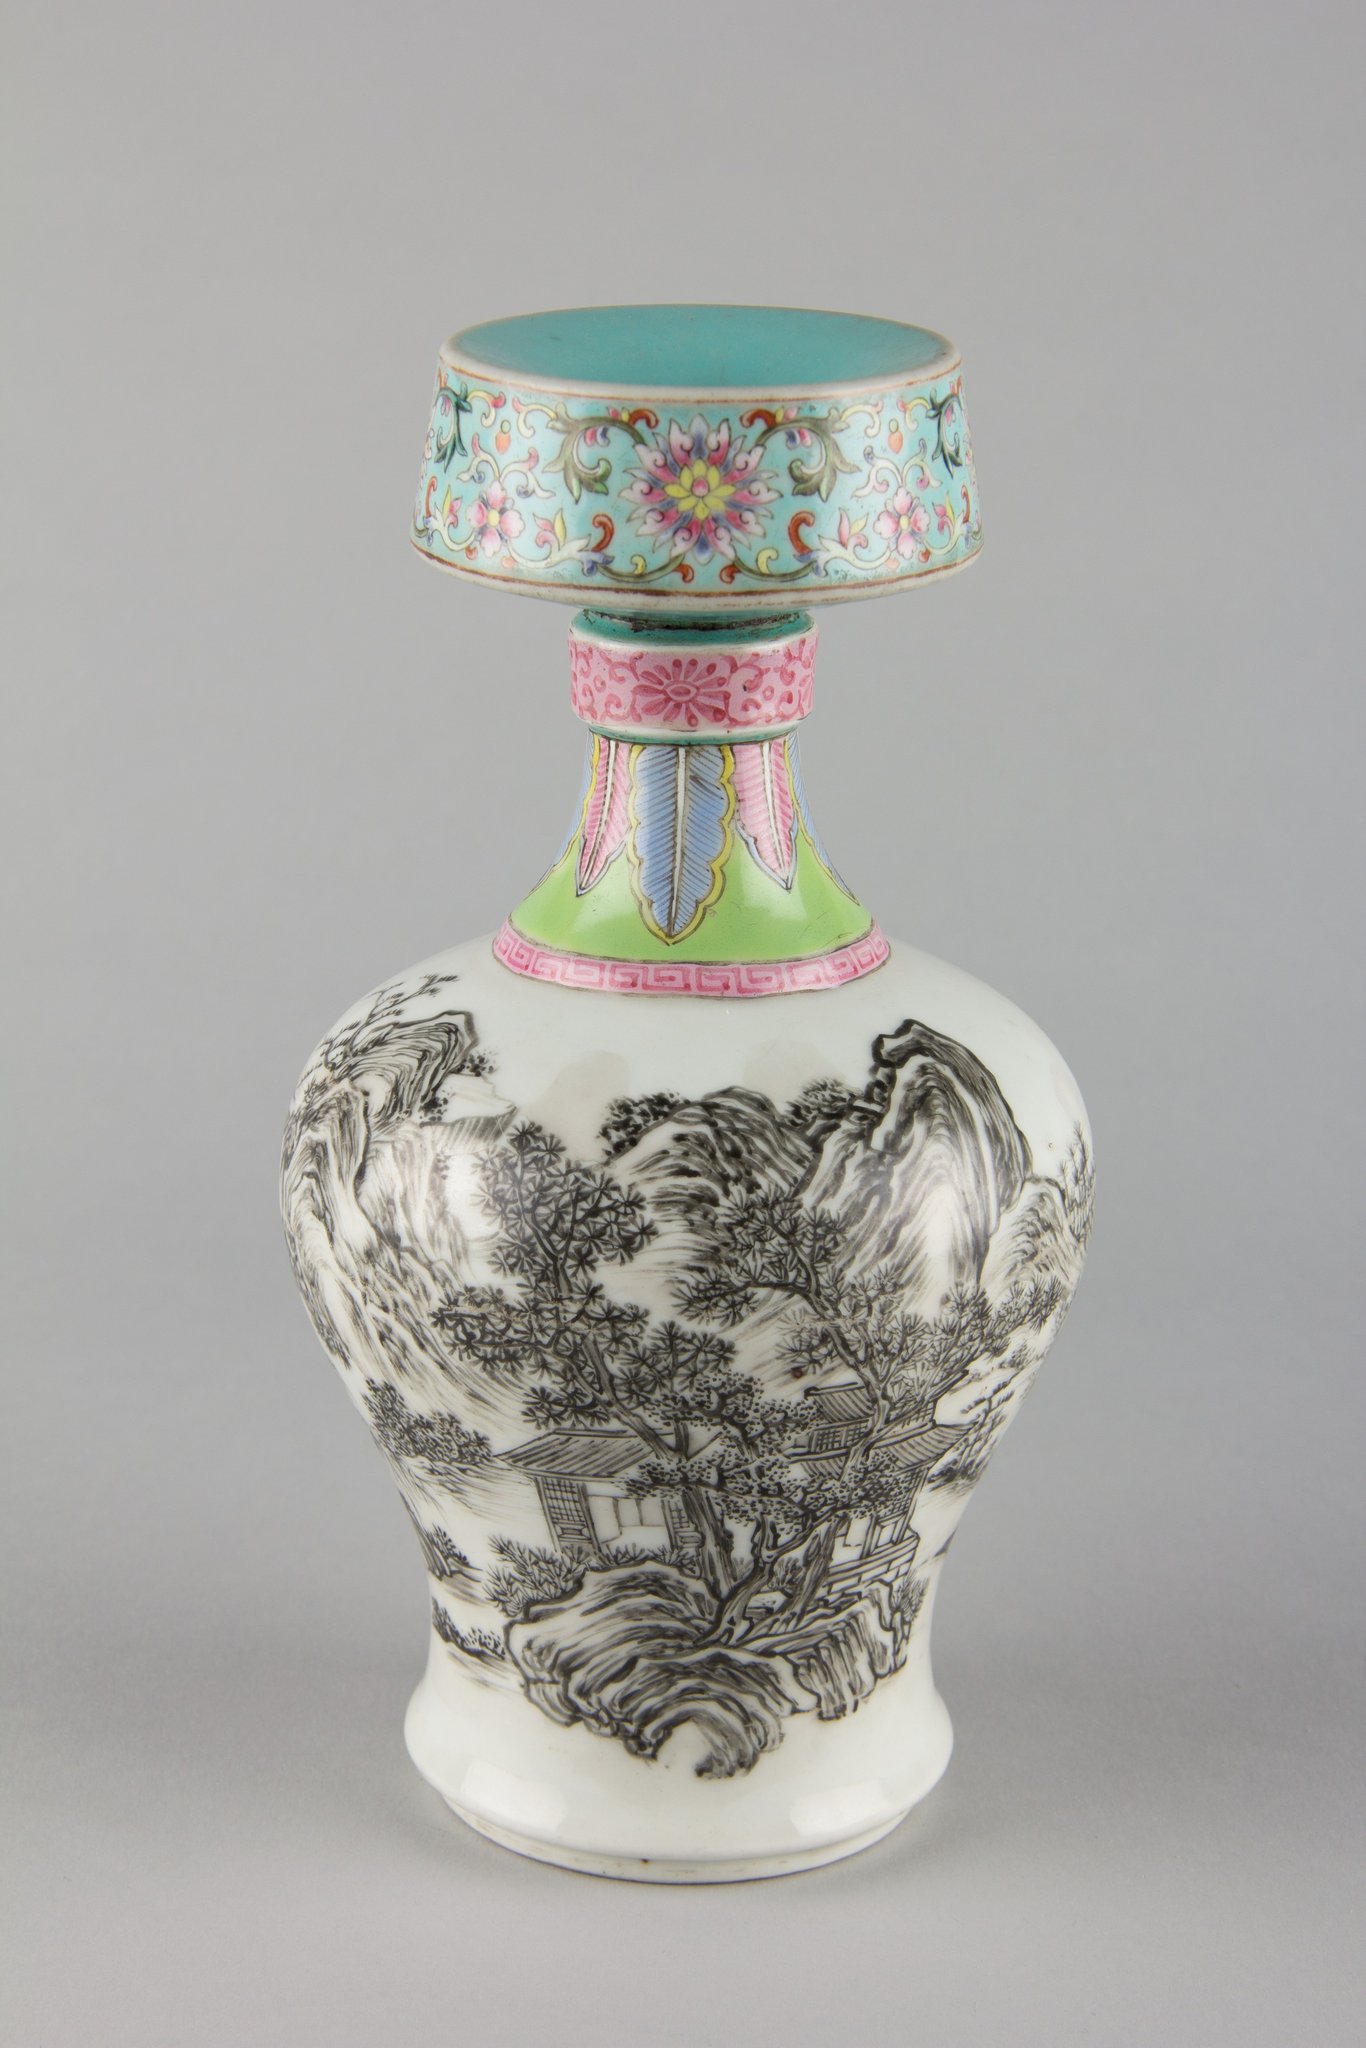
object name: vase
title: Vase with landscape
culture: chinese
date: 1767-1800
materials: enamel, porcelain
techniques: overglaze, painting, polychrome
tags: houses,landscapes,trees